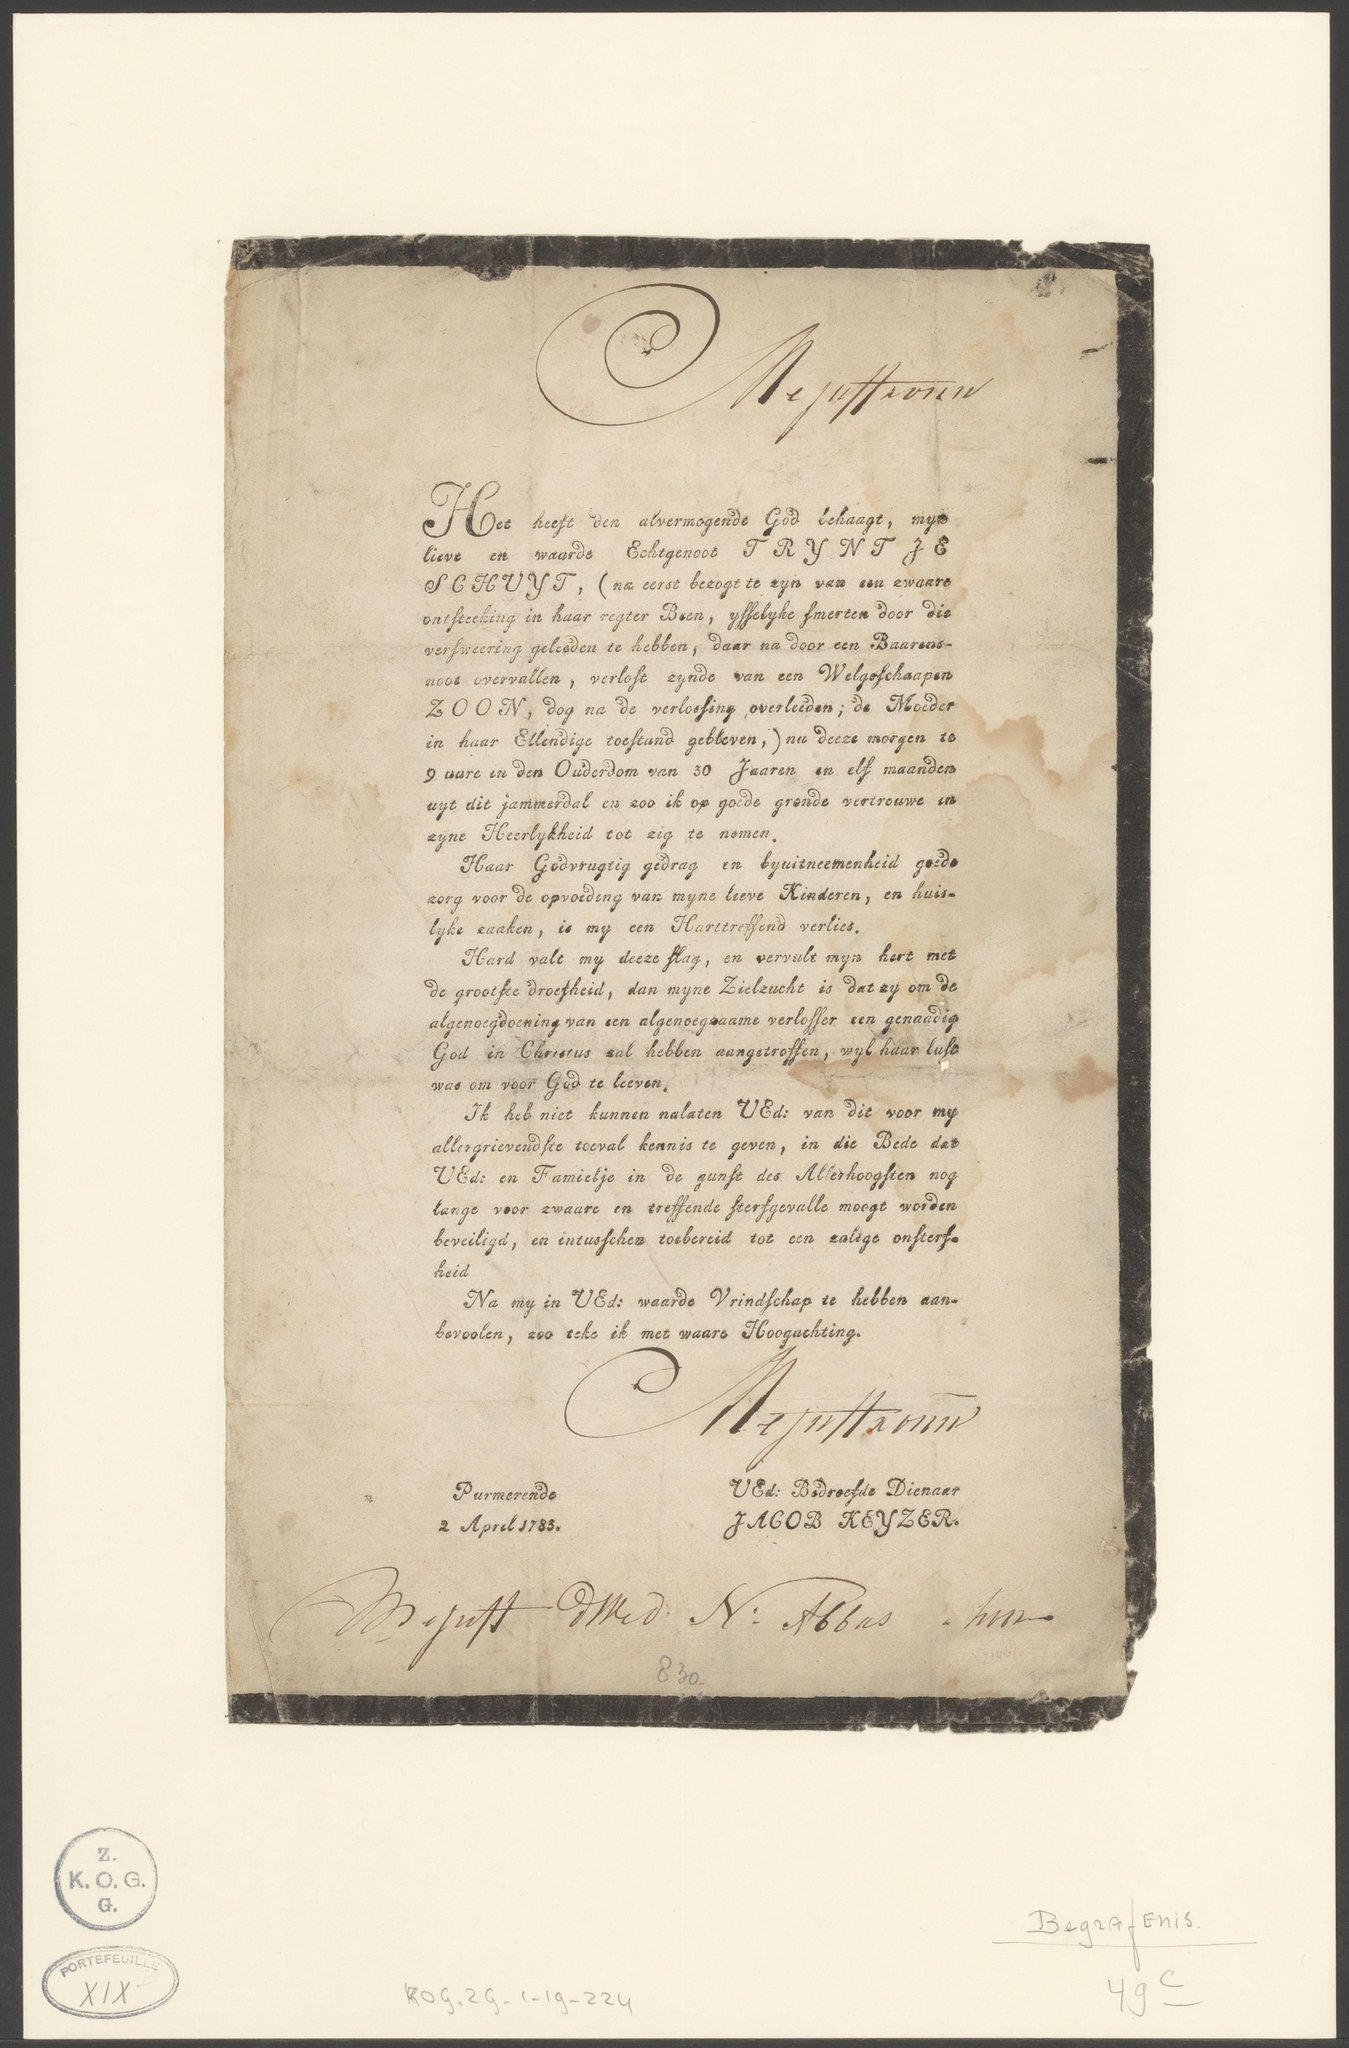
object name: text sheet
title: Overlijdensbericht van Tryntje Schuyt, 2 april 1783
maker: Anonymous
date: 1704-1783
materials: paper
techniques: letterpress printing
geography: purmerend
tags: mourning card, death notice, obituary, amsterdam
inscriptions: collector's mark: Lugt 1641, collector's mark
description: Overlijdensbericht met kennisgeving door Jacob Keyzer van het overlijden van zijn vrouw Tryntje Schuyt, op 2 april 1783, te Purmerend. Dubbelgevouwen blad gedrukt met zwarte rouwranden, aan de buitenzijde geadresseerd aan Mej. Wed. Nanning Abbas, te Hoorn. Onderwerpsrubrieken binnen de Atlas Zeden en Gewoonten: Des Menschen Begin, Midden en Einde. Begrafenissen, begrafenisbriefjes.